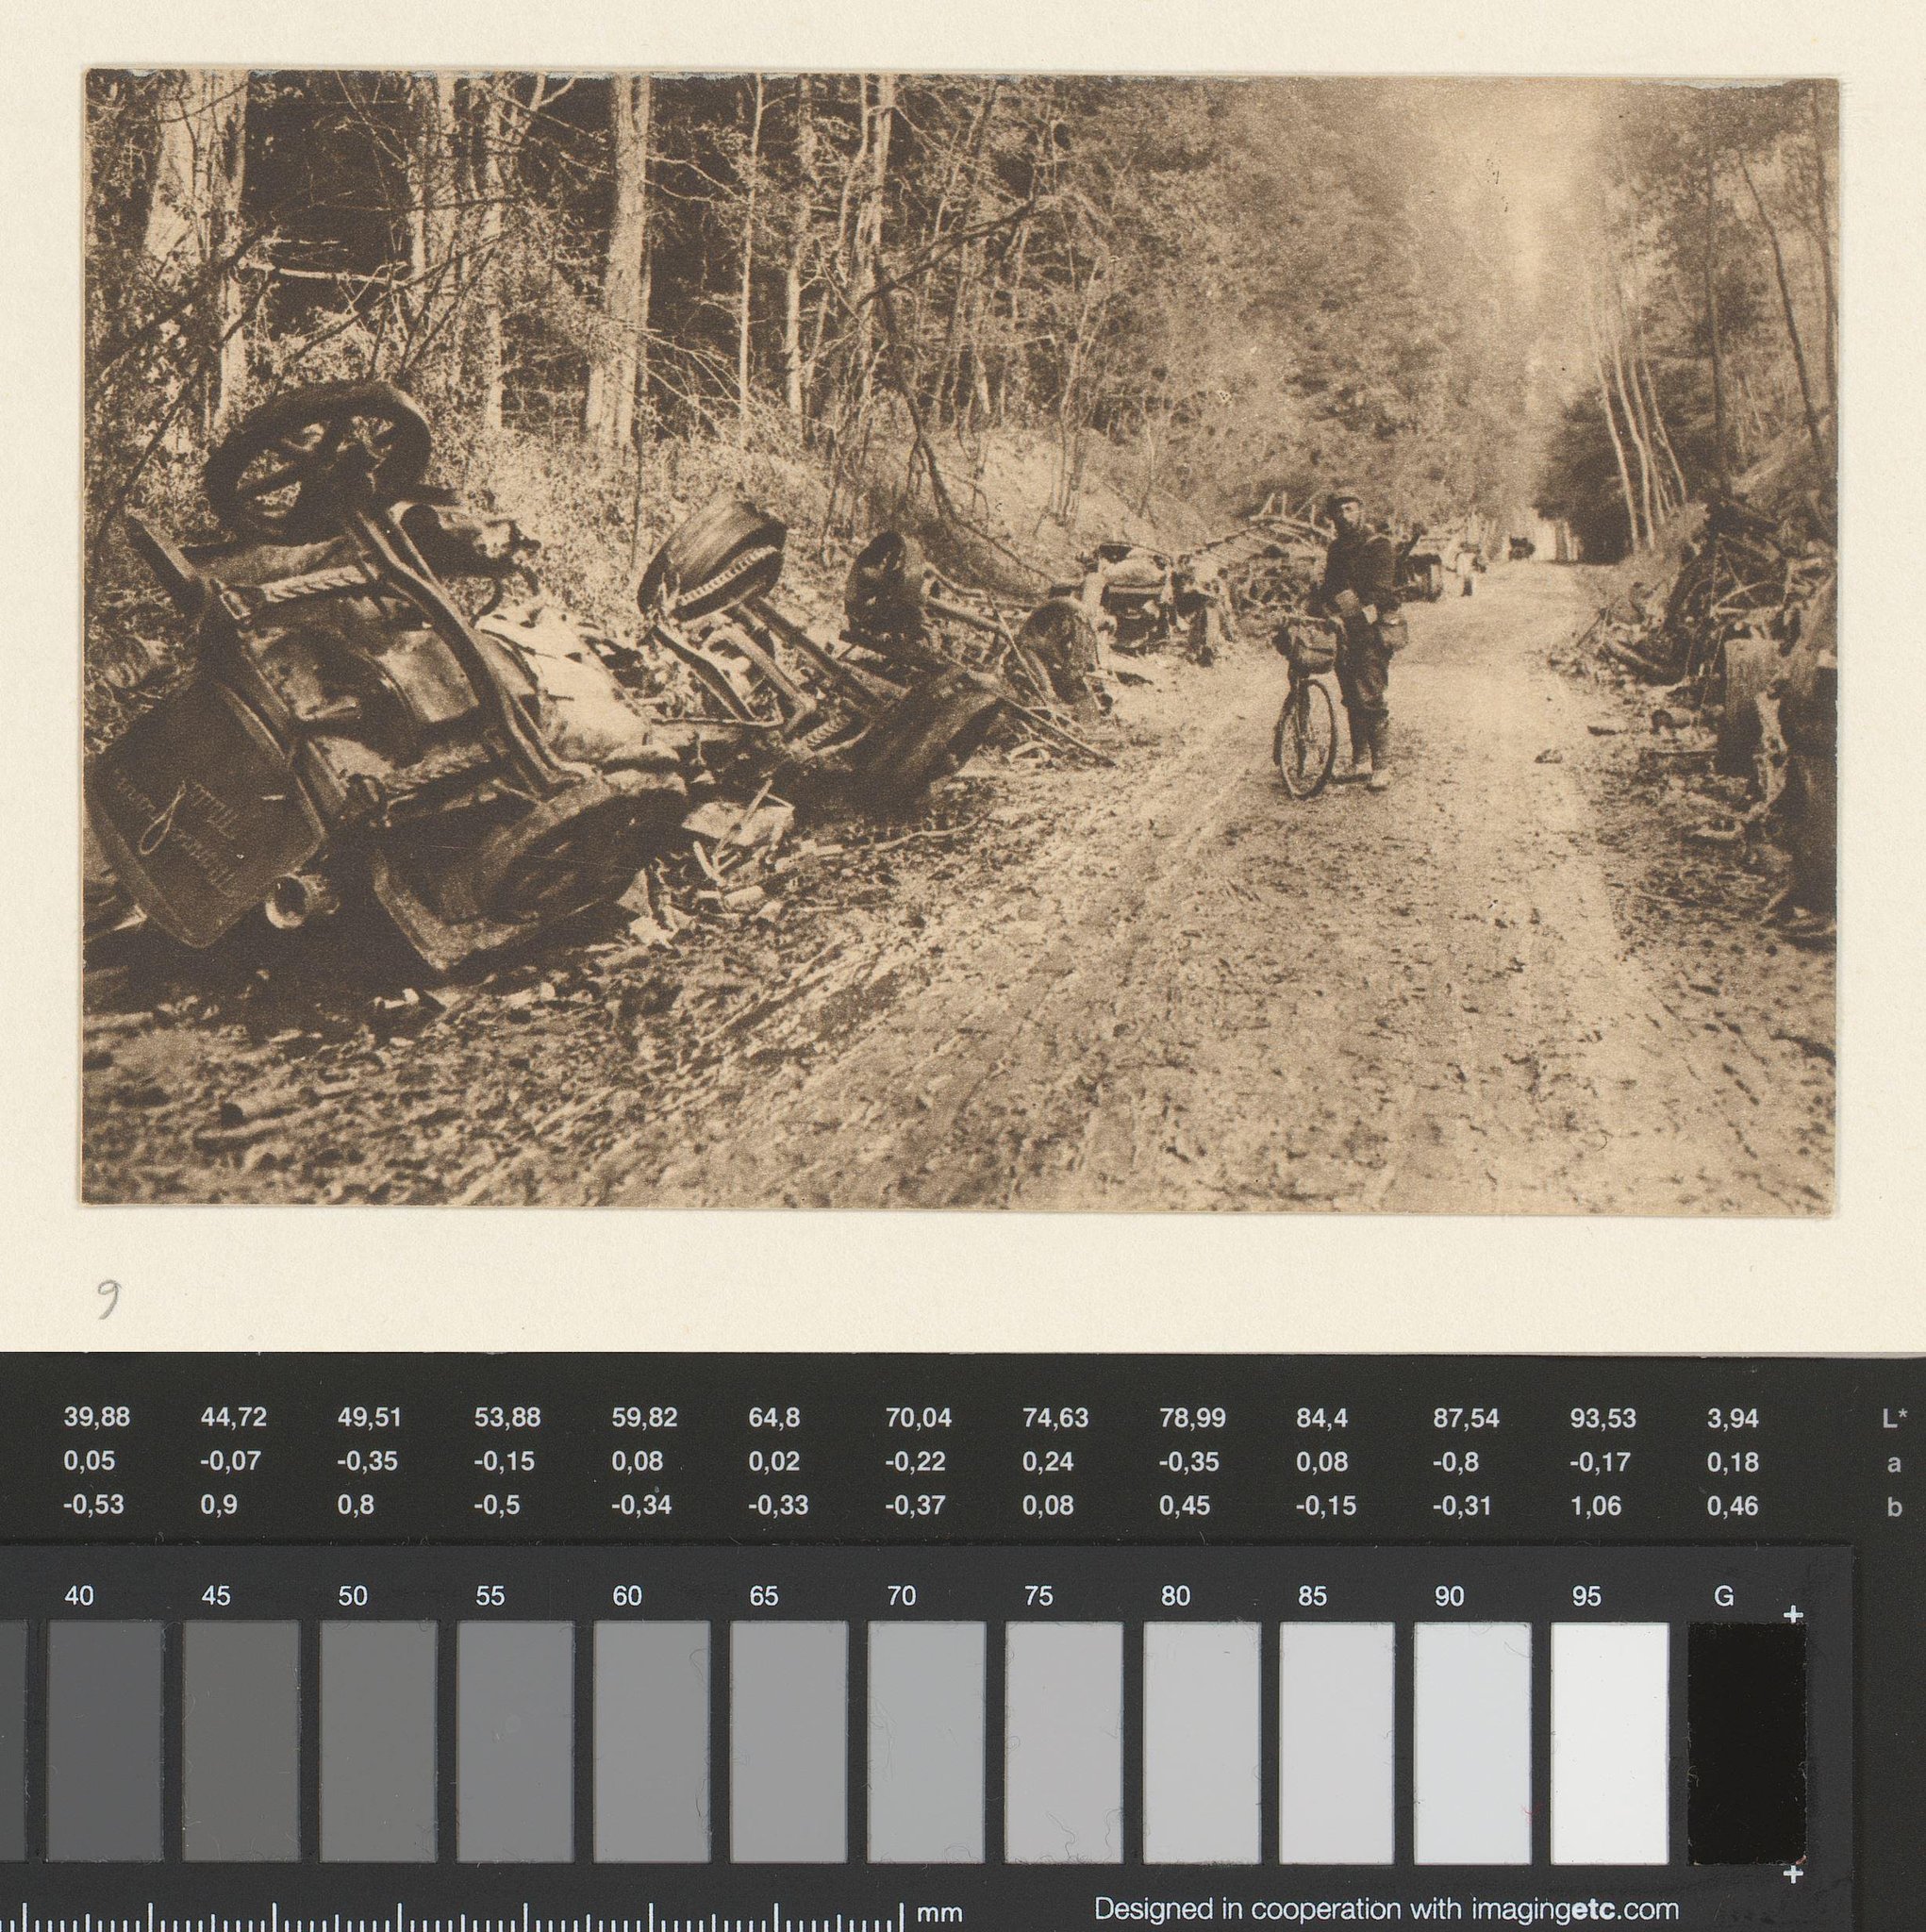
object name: ansichtkaart, prentbriefkaart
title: 12 cartes postales illustrées de la Grande Guerre / Pochette No 1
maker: sémaphore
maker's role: printer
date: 1914-1915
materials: paper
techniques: photograph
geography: marseille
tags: truck, van, modern forms of military vehicles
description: Vernietigde colonne Duitse vrachtwagens. Onderdeel van de eerste serie van twaalf (elf aanwezig) prentbriefkaarten over de Eerste Wereldoorlog, 1914-1915.